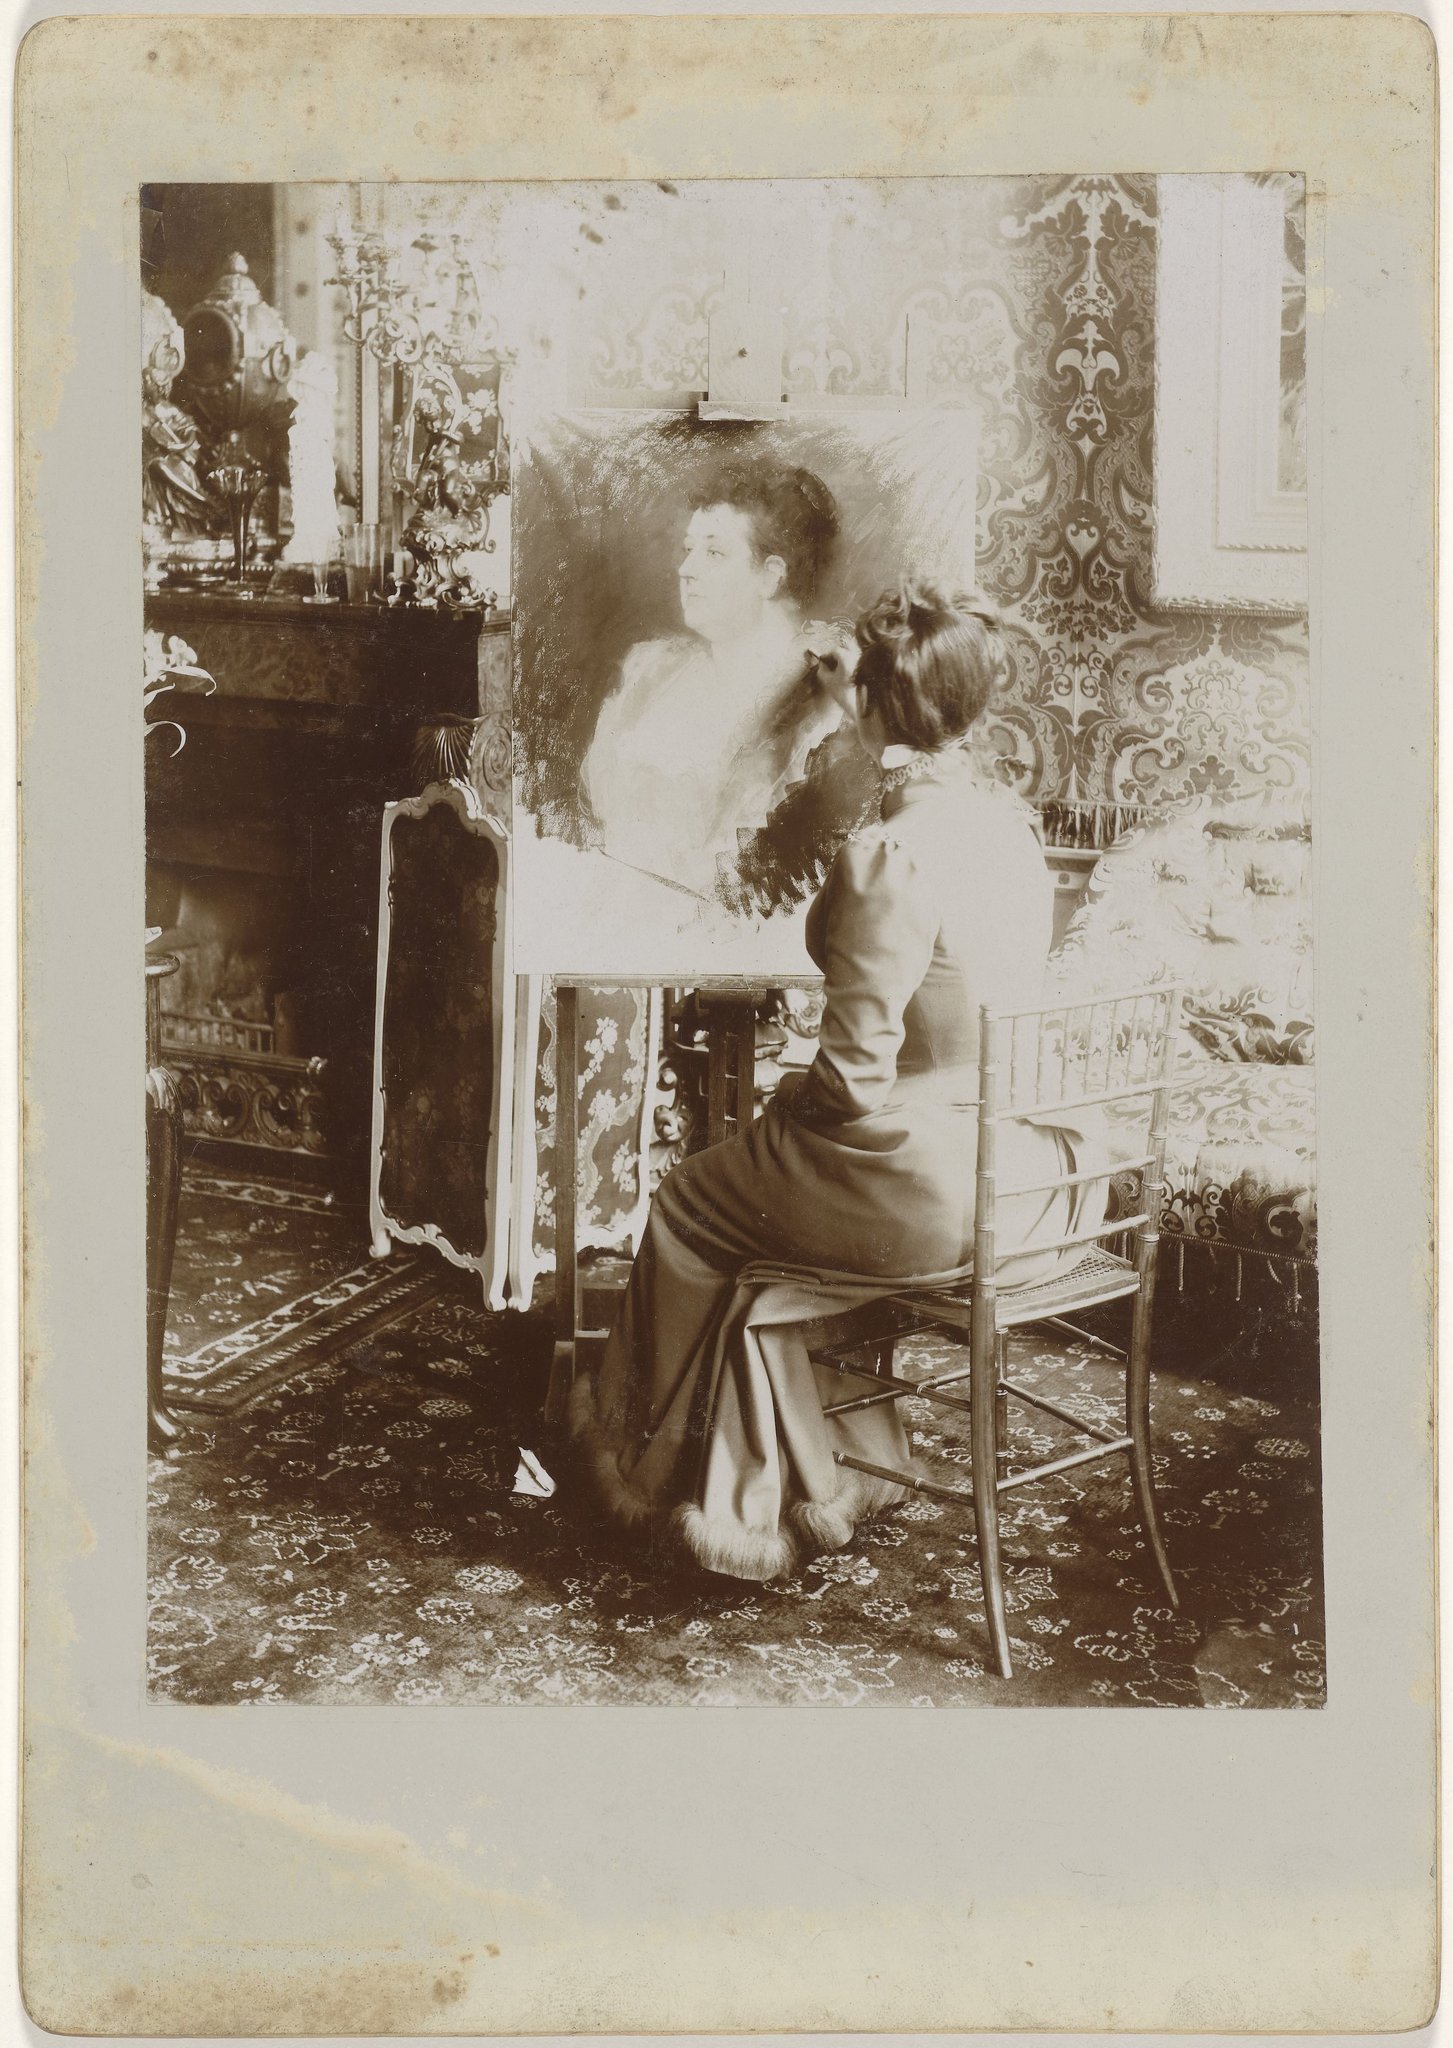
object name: photograph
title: Thérèse Schwartze tijdens het schilderen van een vrouwsportret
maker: Anonymous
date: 1890-1918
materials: cardboard, paper, photographic support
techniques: collodion silver print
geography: netherlands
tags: amsterdam, painter, print maker, thérèse schwartze, artist at work, in his workshop